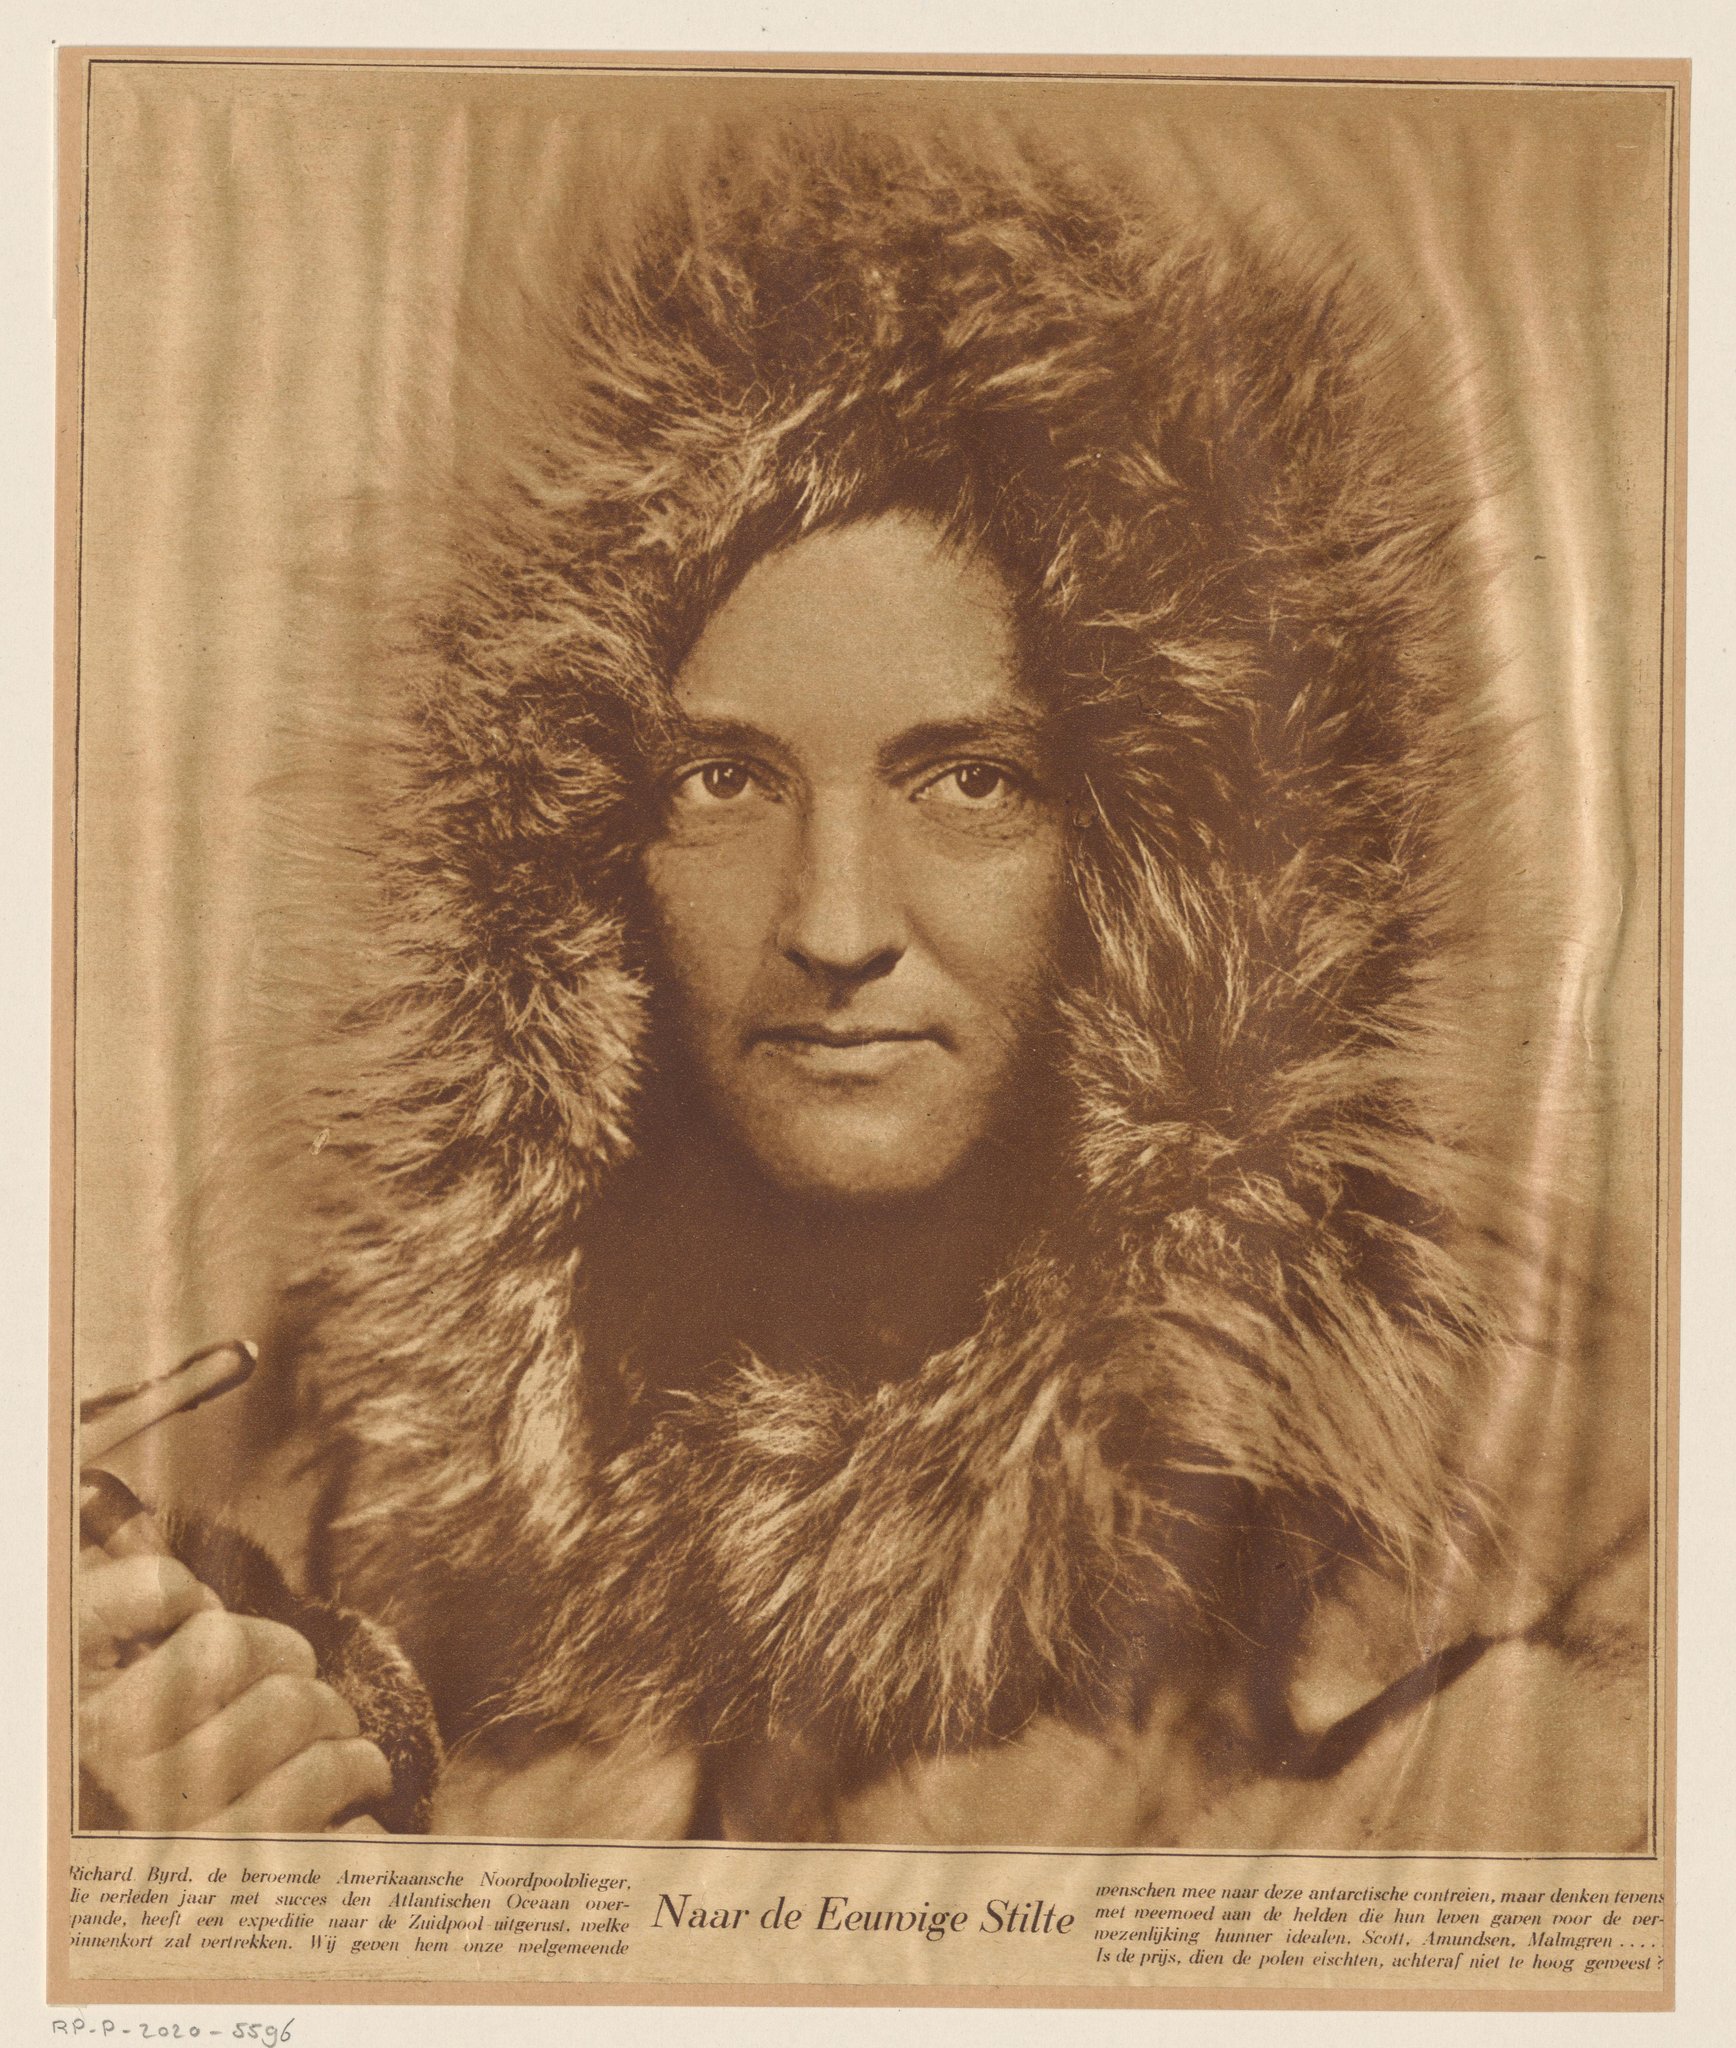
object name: photomechanical print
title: Portret van Richard Evelyn Byrd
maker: Anonymous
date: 1927-1928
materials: paper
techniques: rotogravure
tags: historical persons, explorer